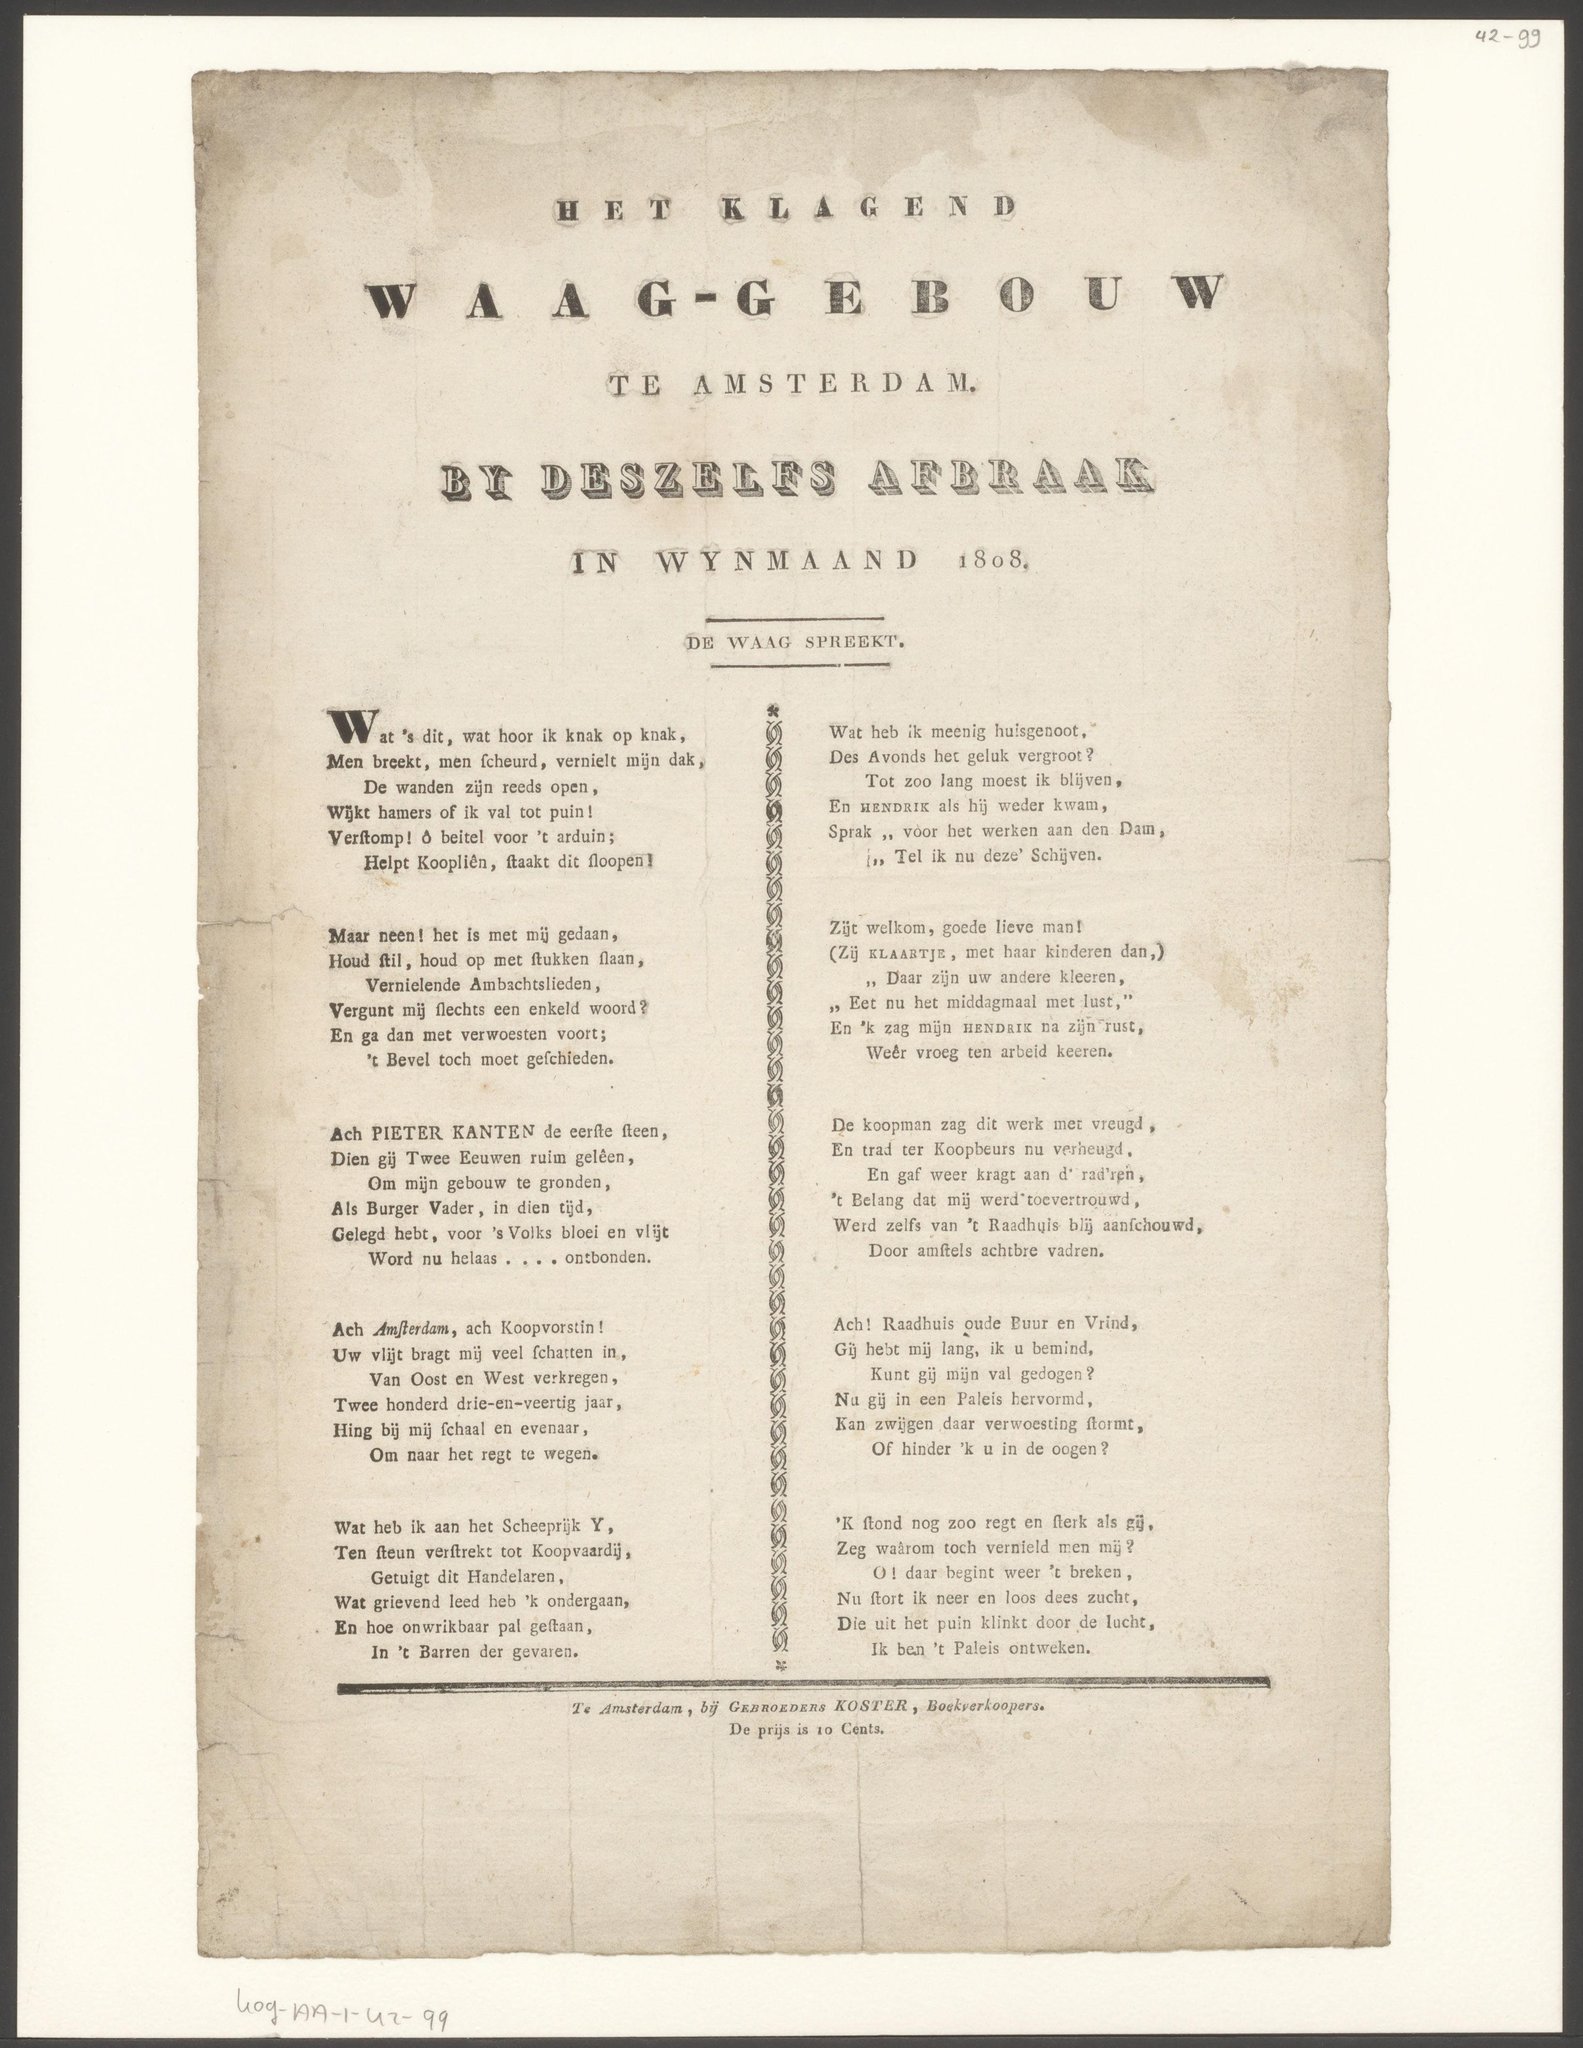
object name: text sheet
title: Klaagzang op de afbraak van de Waag, 1808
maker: Anonymous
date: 1808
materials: paper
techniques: letterpress printing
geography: amsterdam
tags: weigh-house, amsterdam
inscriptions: collector's mark: Lugt 1641b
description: Vers in twee kolommen. Onderwerpsrubriek binnen de Atlas Amsterdam: Markten, handel: C. Veemen, Waaggebouwen.